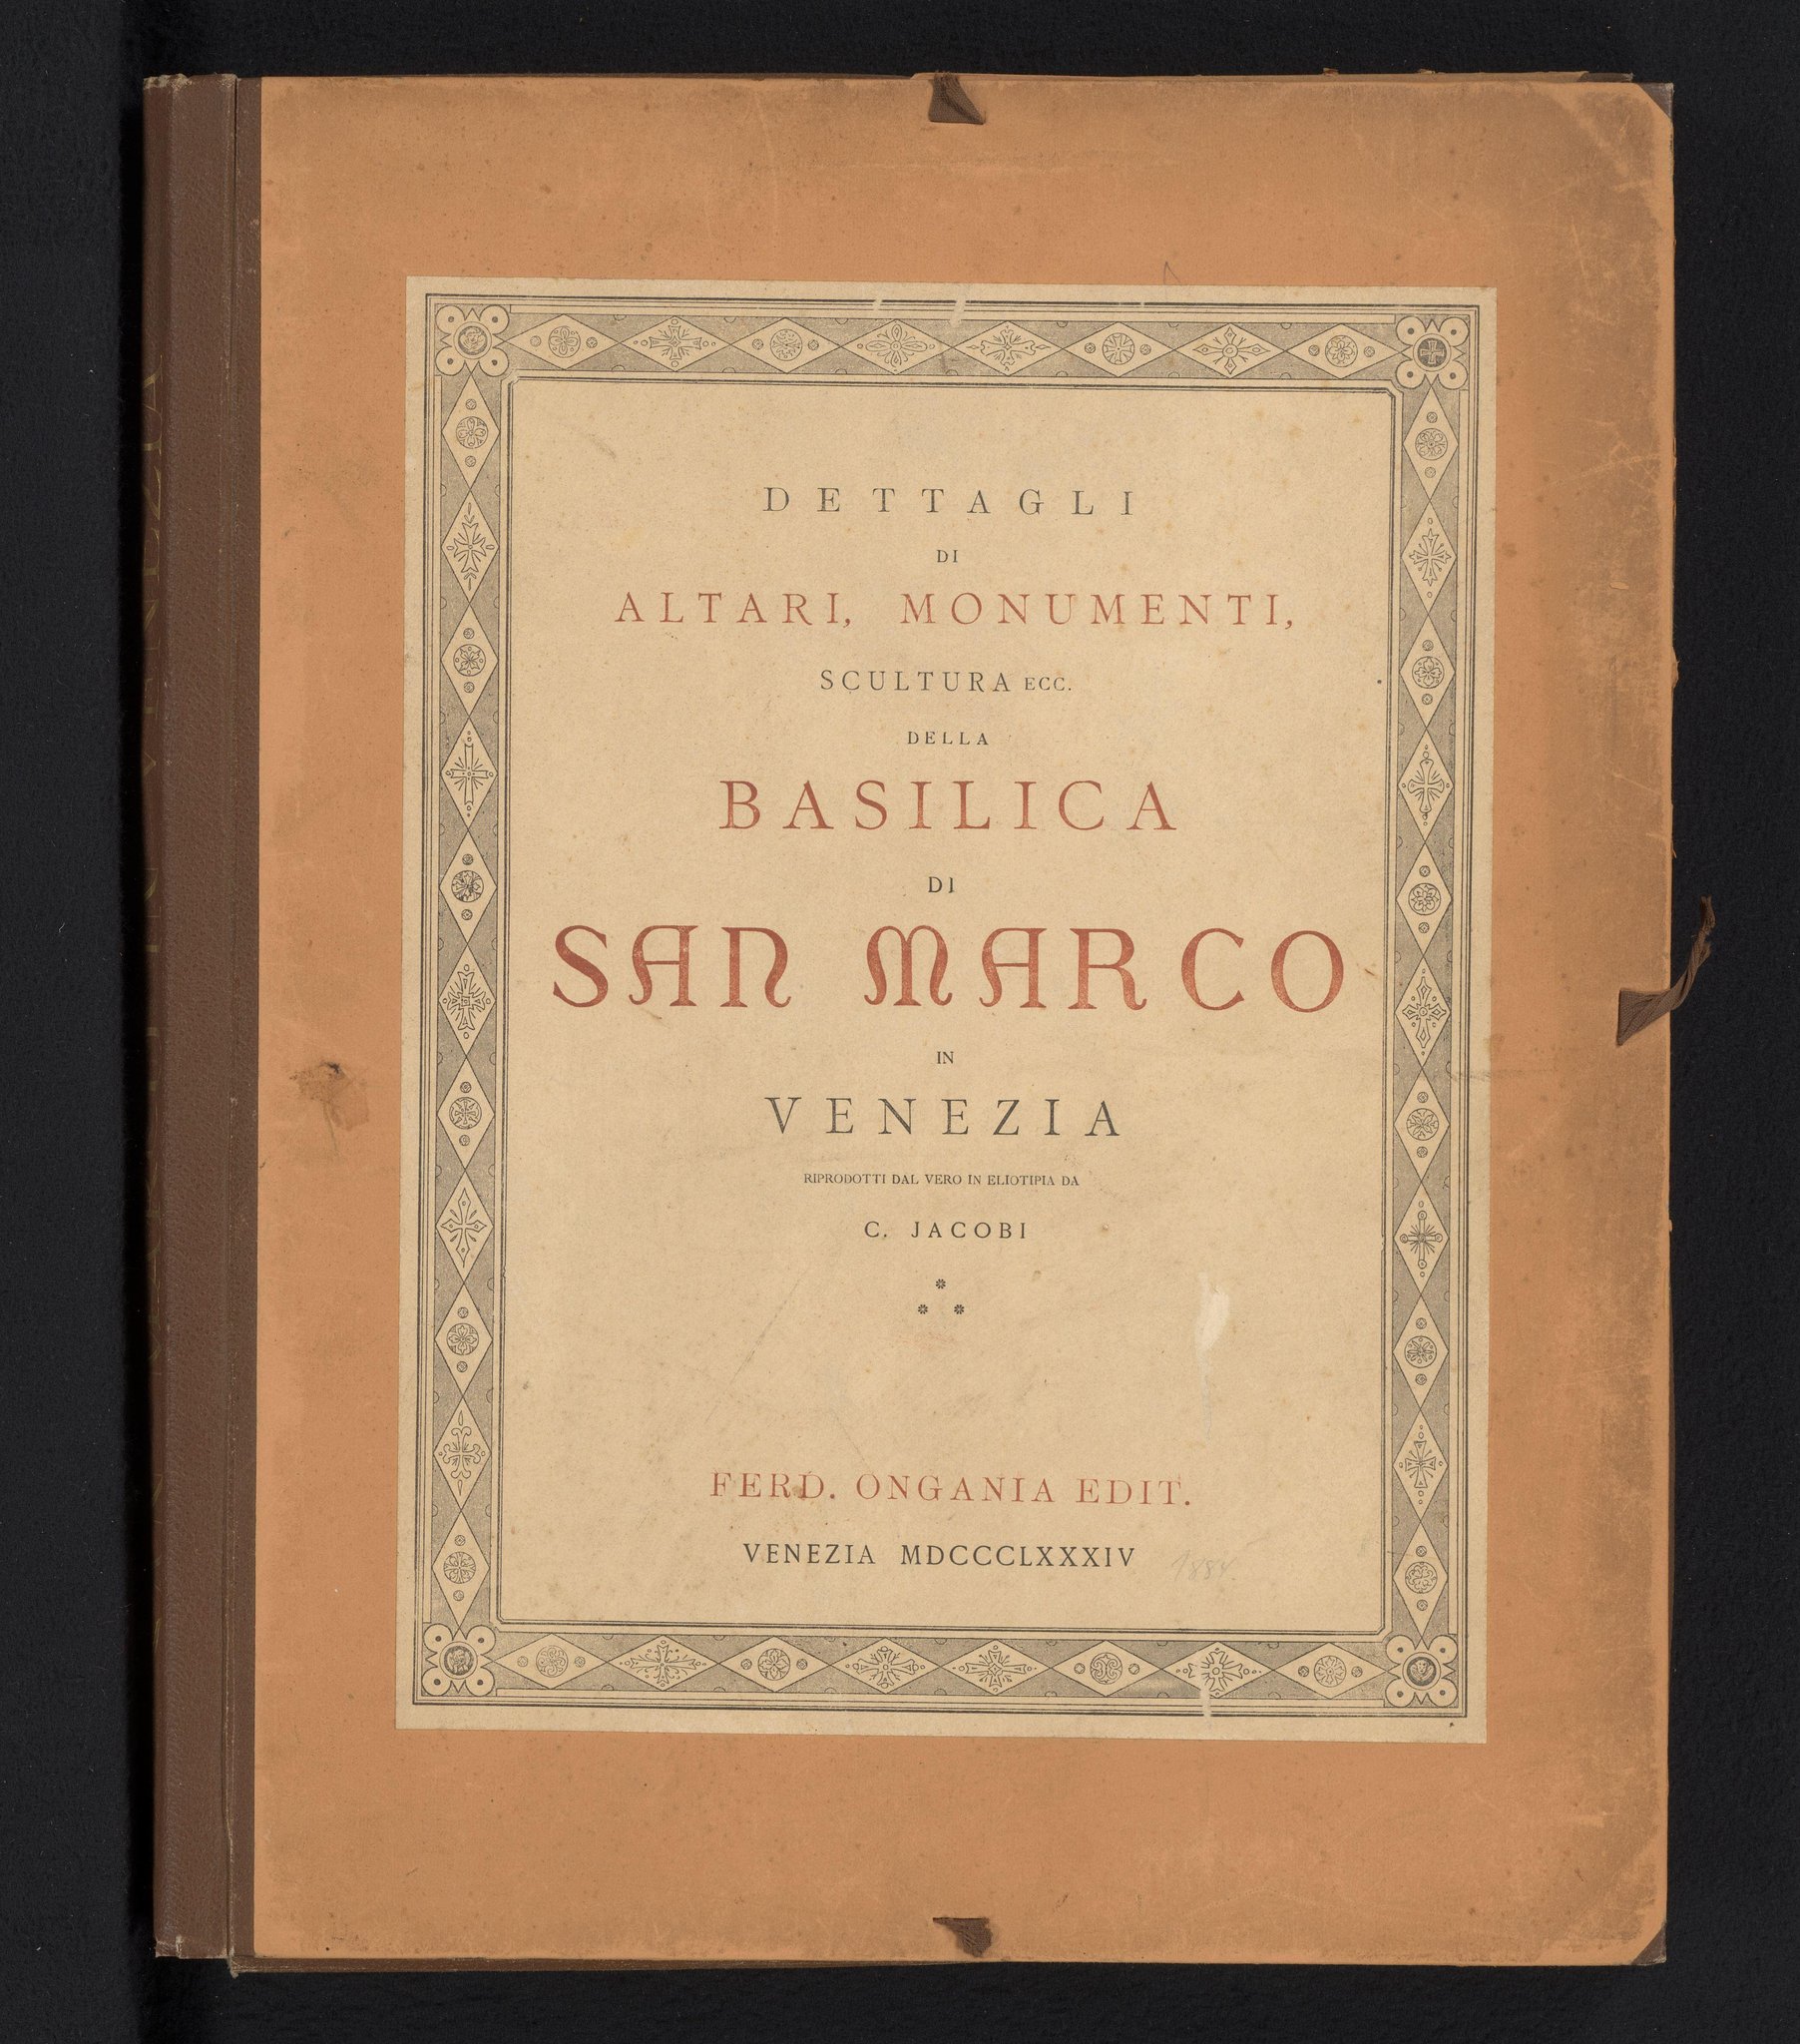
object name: wrapper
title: Dettagli di altari, monumenti, scultura ecc. della Basilica di San Marco in Venezia / riprodotti dal vero in eliotipia da C. Jacobi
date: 1884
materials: cardboard, linen, paper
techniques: photograph, printing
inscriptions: inscription: ‘Portafolgio N.o V./ Coperta 3./ Contiene Tav. 98 a. 142.’, date: ‘SEPT/ 1998’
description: Omslag met 51 prenten op 29 bladen en 1 tekstblad.